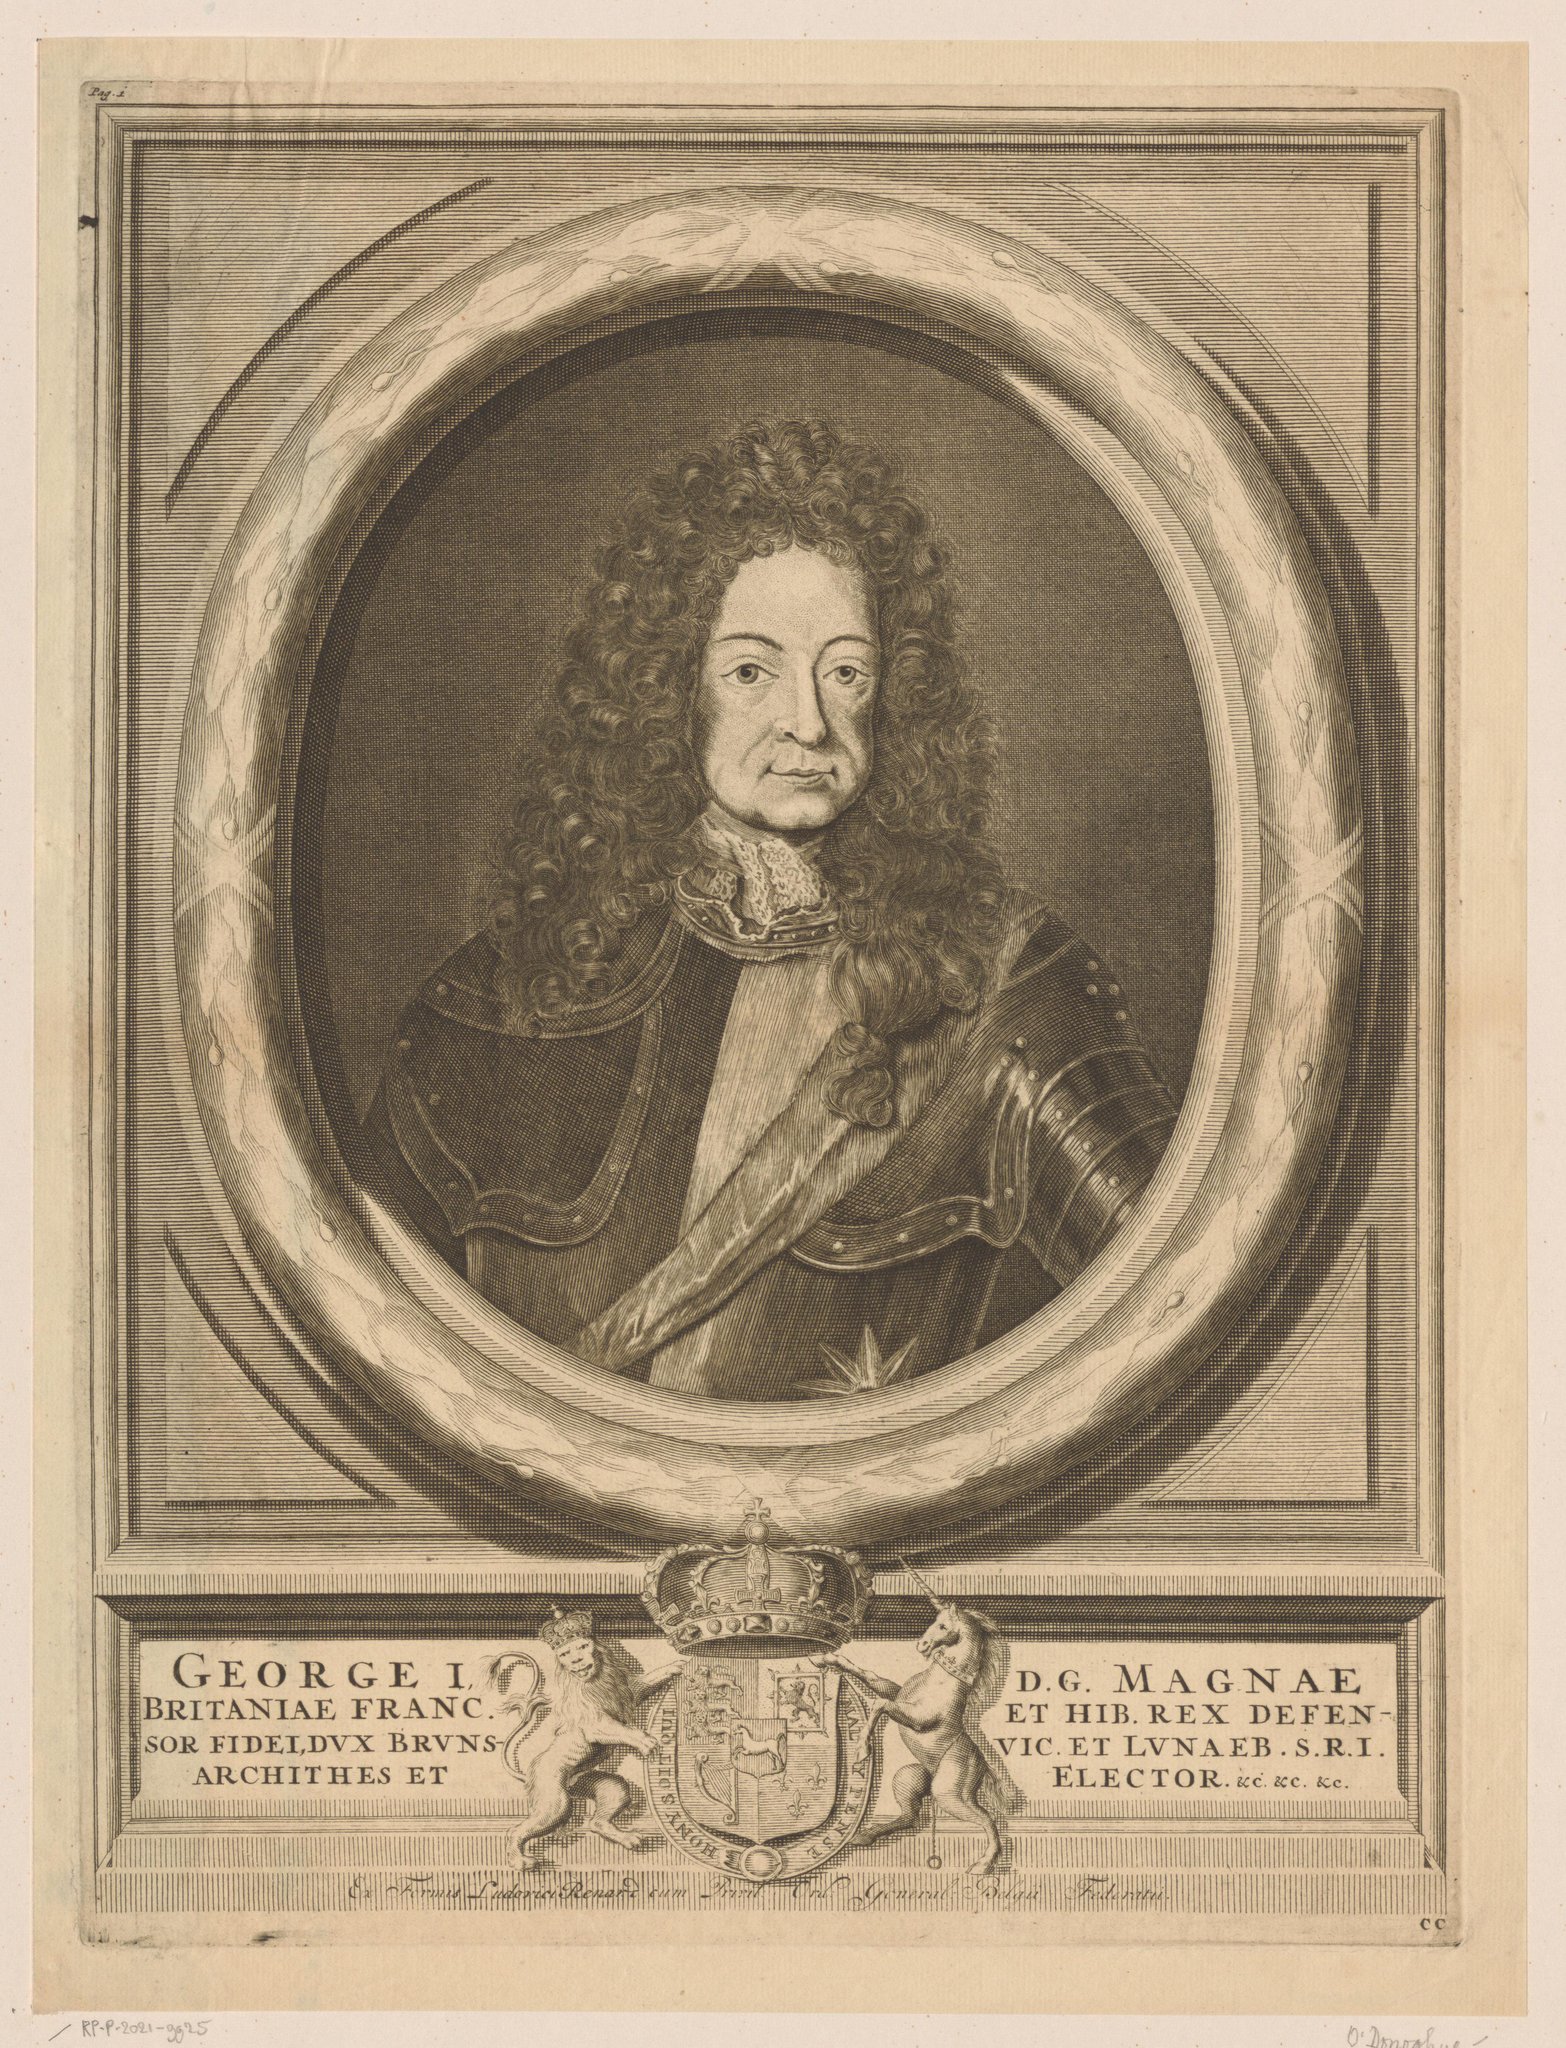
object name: print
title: Portret van George I, koning van Groot-Brittannië en Ierland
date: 1708-1724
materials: paper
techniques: engraving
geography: amsterdam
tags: george i (koning van groot-brittannië en ierland), historical persons, king, armorial bearing, heraldry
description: Onder het portret zijn wapenschild. Linksboven genummerd: Pag. 1. Rechtsonder genummerd: CC.